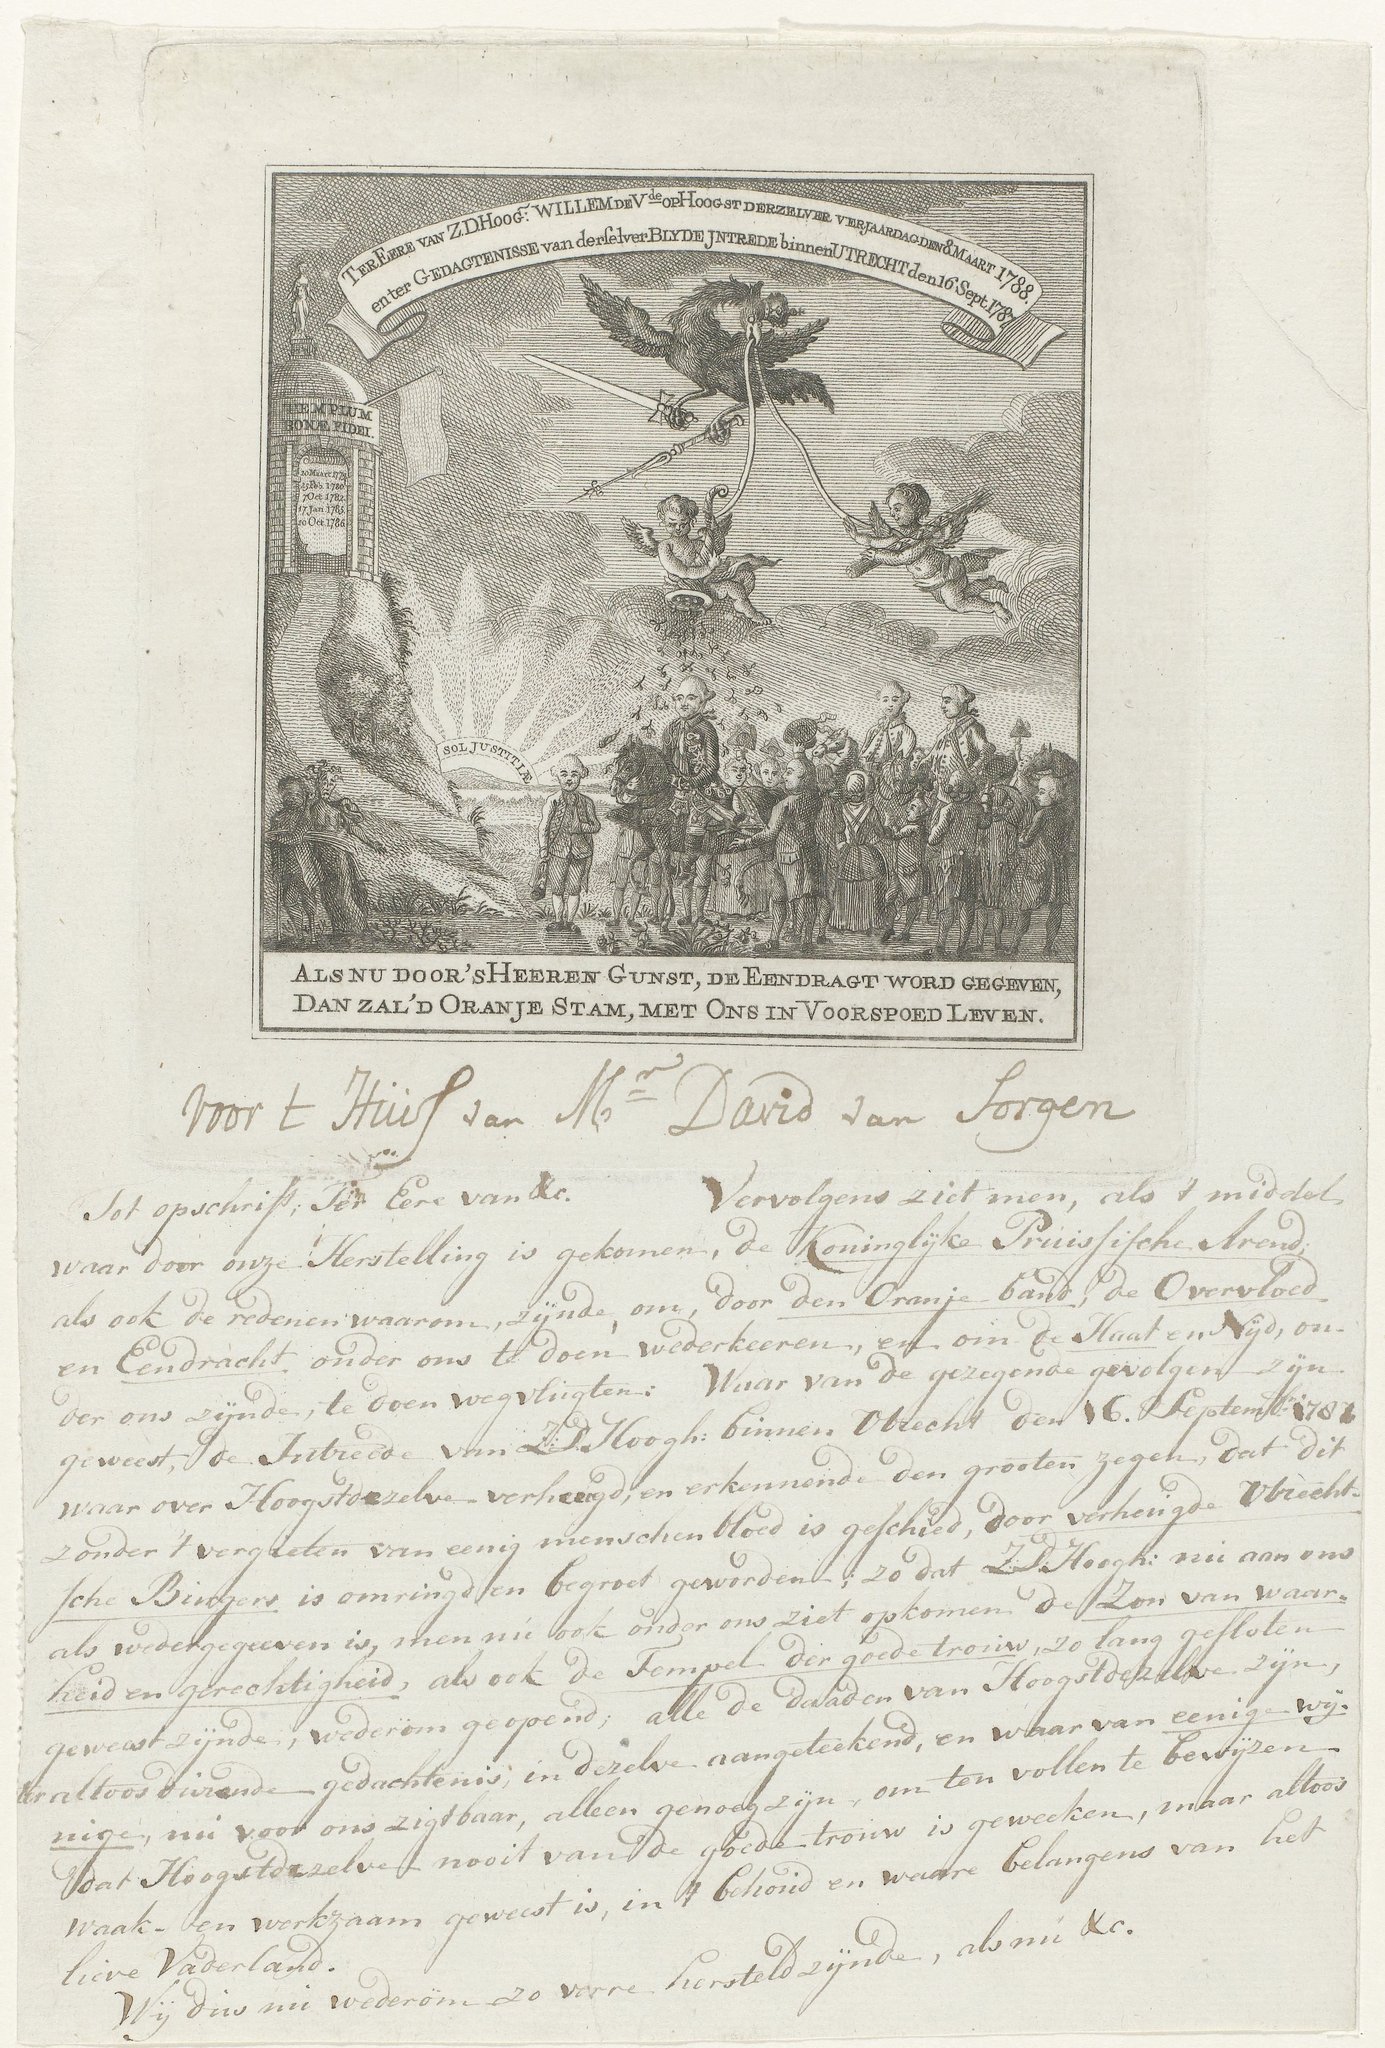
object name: print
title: Chassinet met allegorie op de verjaardag van de prins in 1788 en zijn intocht te Utrecht in 1787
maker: Anonymous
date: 1788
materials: paper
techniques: engraving, etching, writing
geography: northern netherlands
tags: the hague, william v (prince of orange), utrecht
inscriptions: collector's mark: Lugt 2228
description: Chassinet met allegorie ter gelegenheid van de veertigste verjaardag van prins Willem V op 8 maart 1788 en ter nagedachtenis aan de intocht van de prins te Utrecht op 16 september 1787. Dit chassinet was onderdeel van de illuminatie van het huis van mr. David van Sorgen te Utrecht. Met tweeregelig onderschrift. Op het blad onder de plaat een lange handgeschreven beschrijving van de voorstelling.